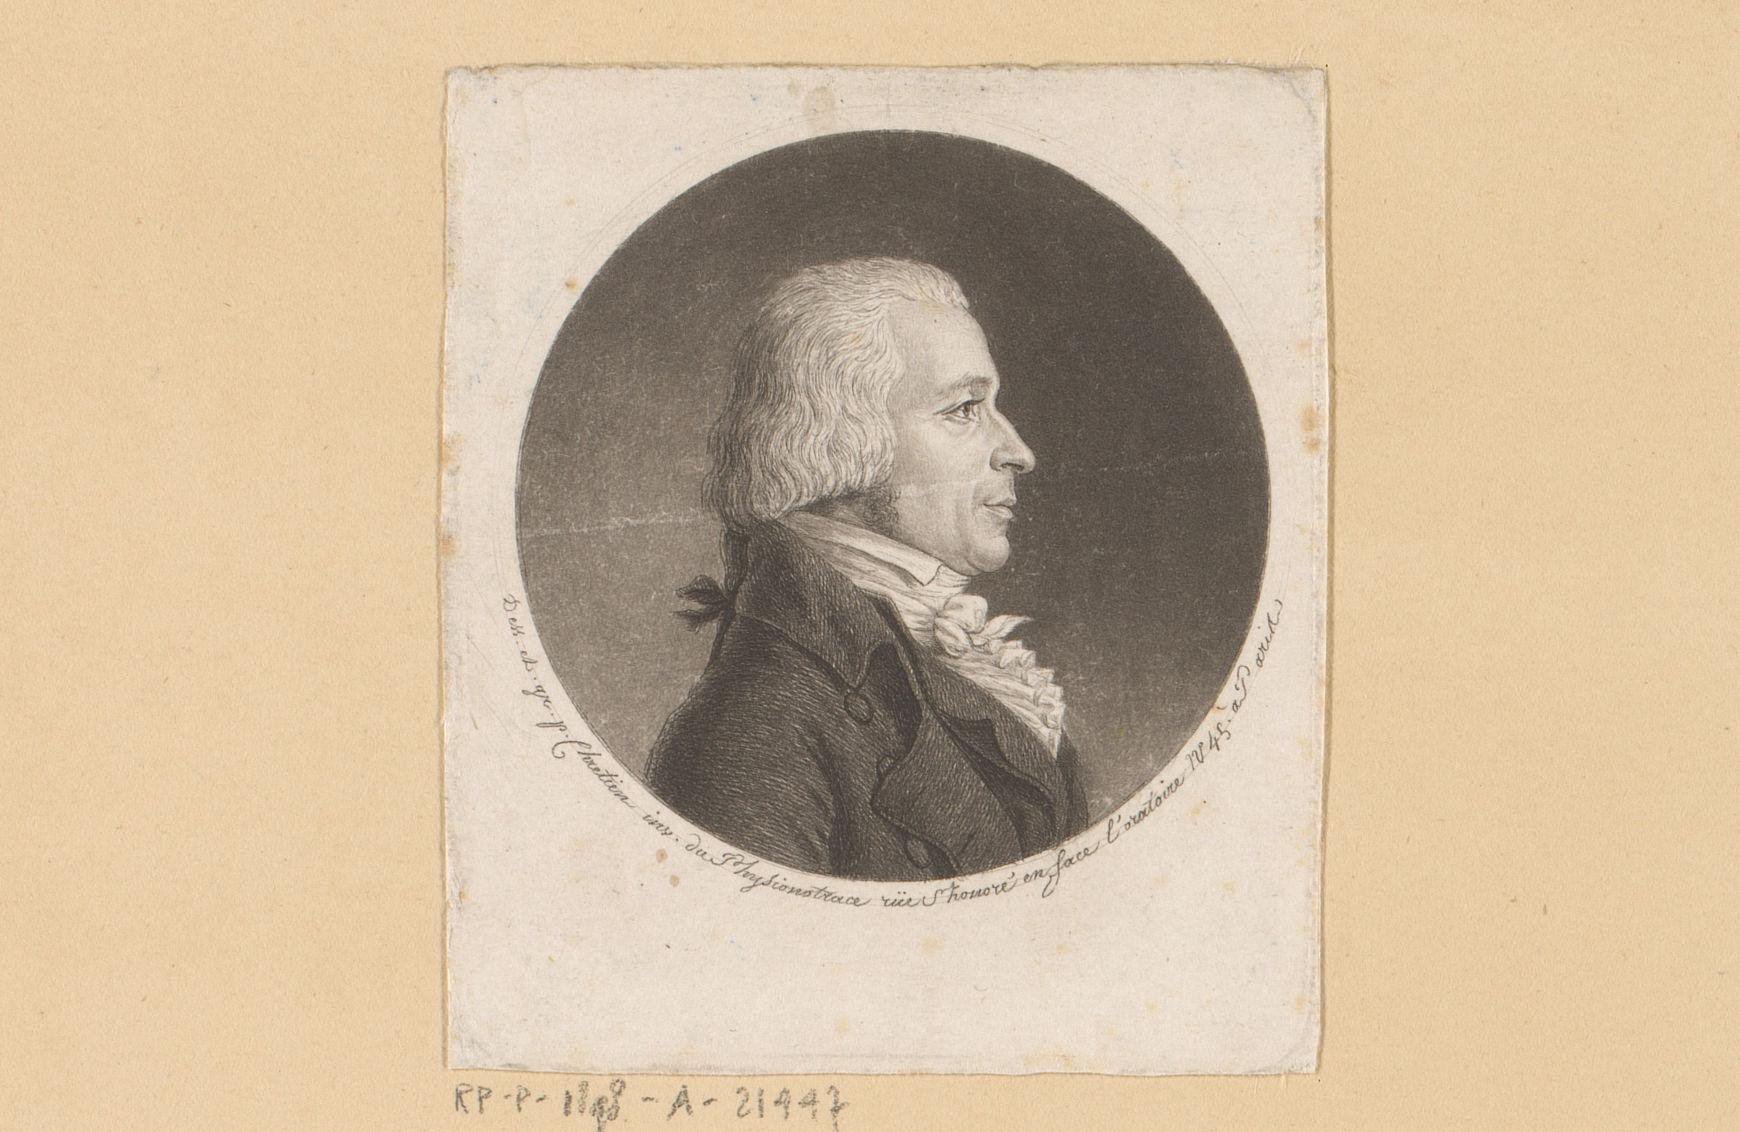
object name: physionotrace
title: Portret van Martinus van Marum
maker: gilles louis chrétien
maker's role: print maker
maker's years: 1754-1811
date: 1785-1811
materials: paper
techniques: aquatint, etching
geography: paris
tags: delft, haarlem, physicist, silhouette-apparatus, 'physionotrace', historical persons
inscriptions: collector's mark: Lugt 964